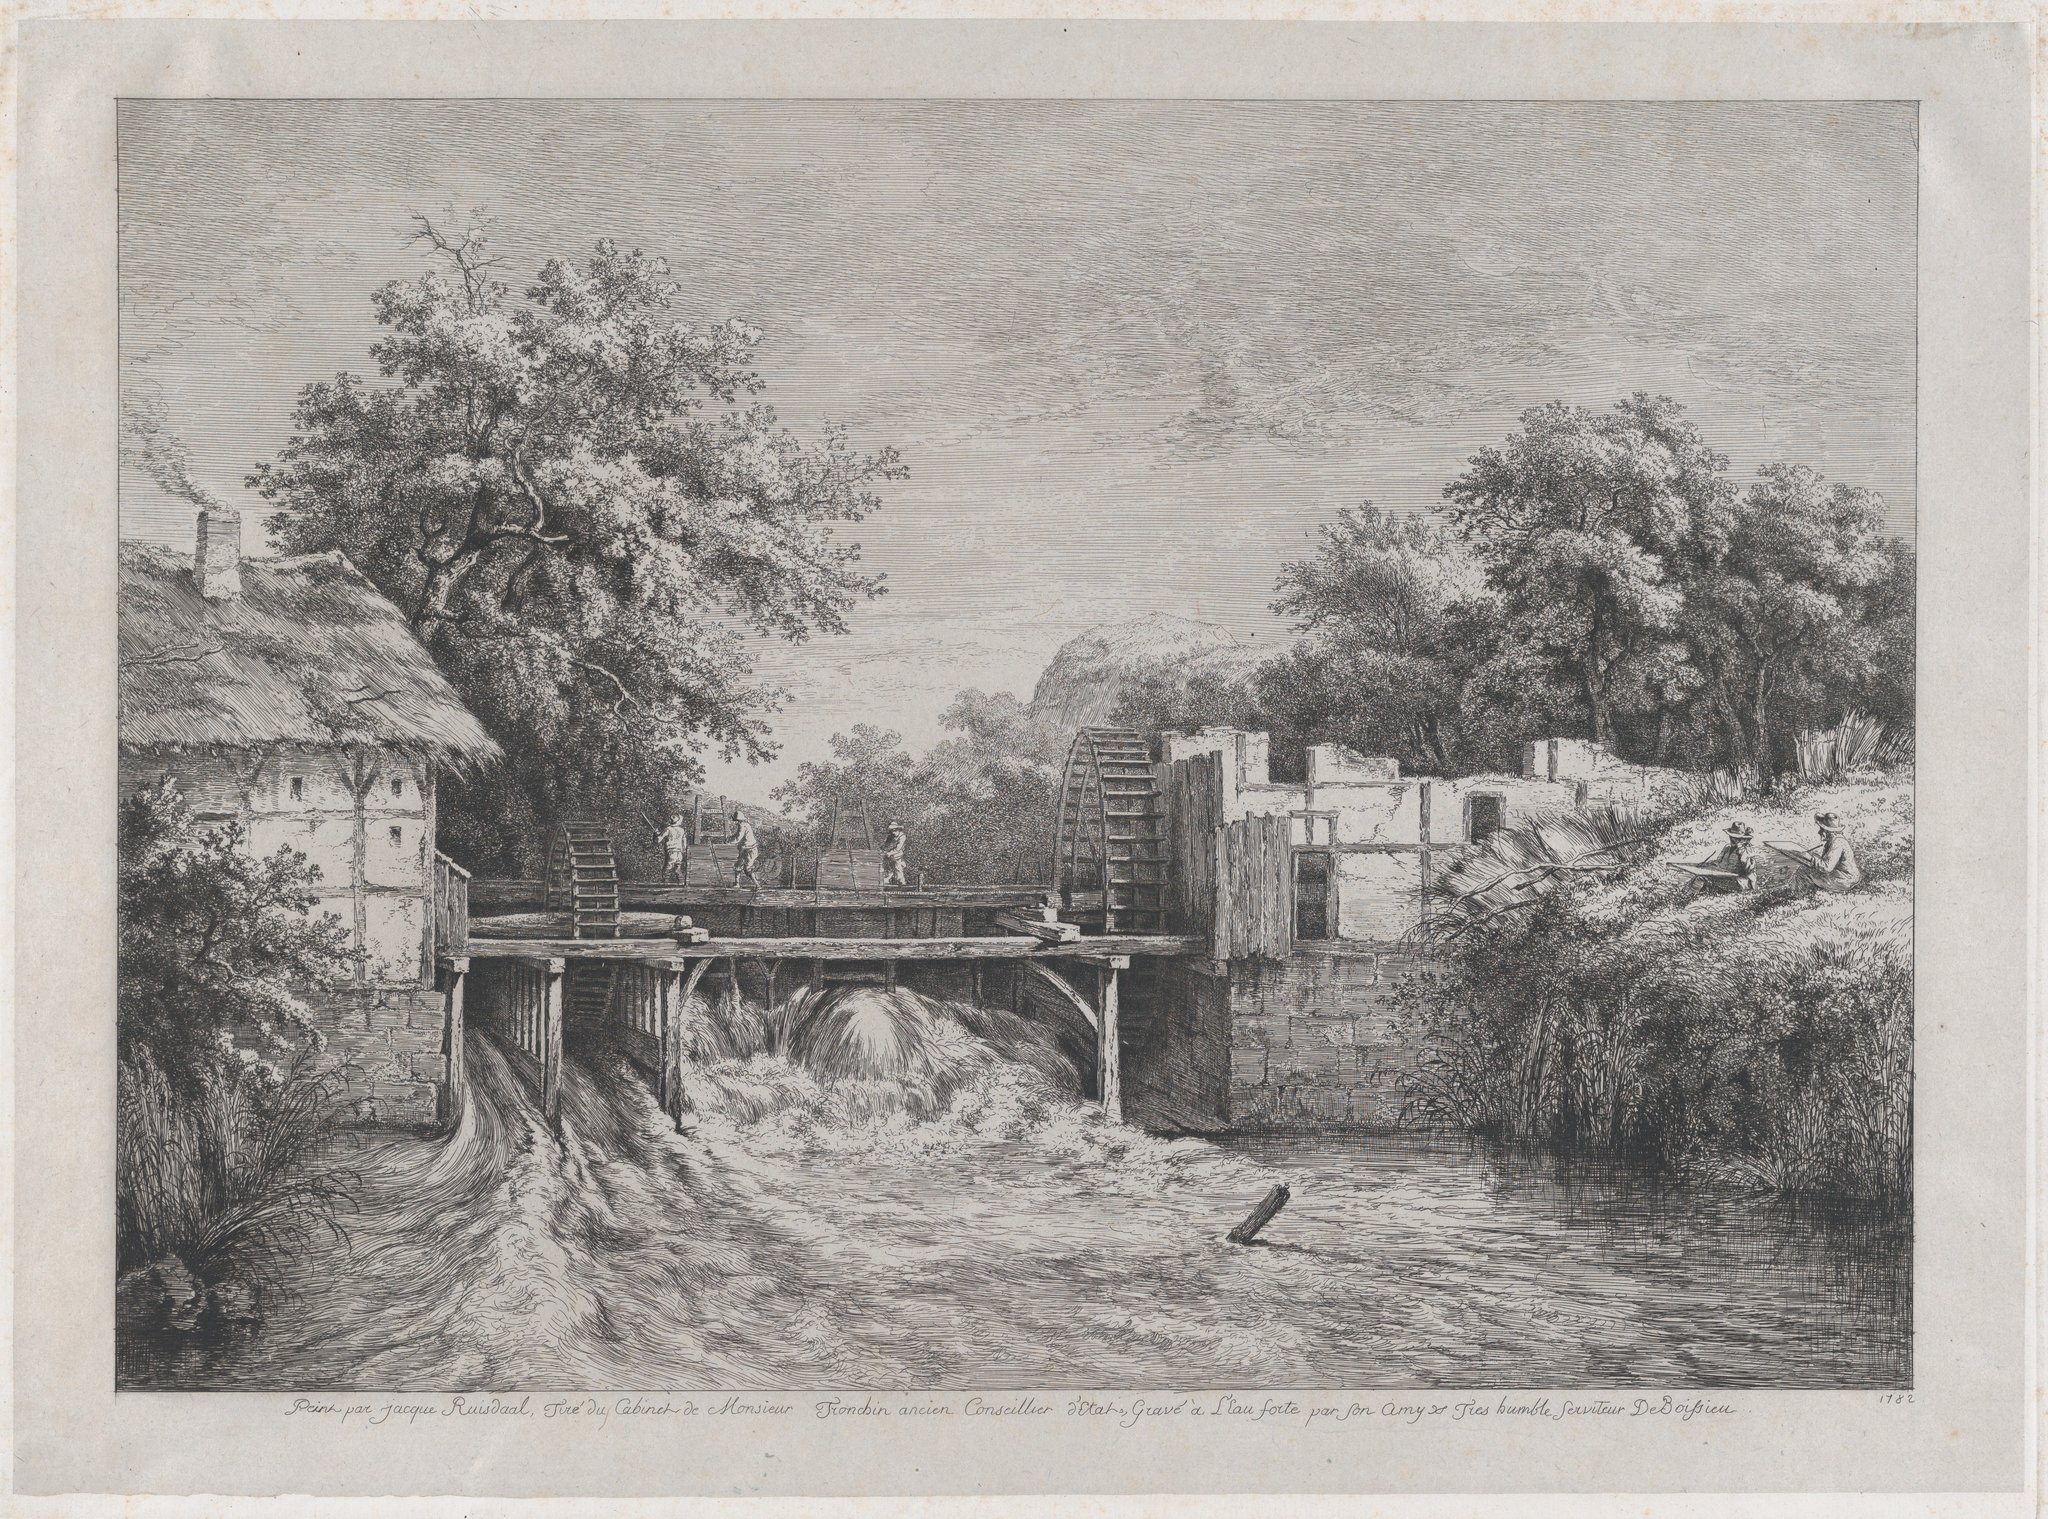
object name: print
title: The Watermill, after a painting by Ruisdaël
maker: jean jacques de boissieu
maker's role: artist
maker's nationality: french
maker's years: 1736-1810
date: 1782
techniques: drypoint, etching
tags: watermills,men,trees,working